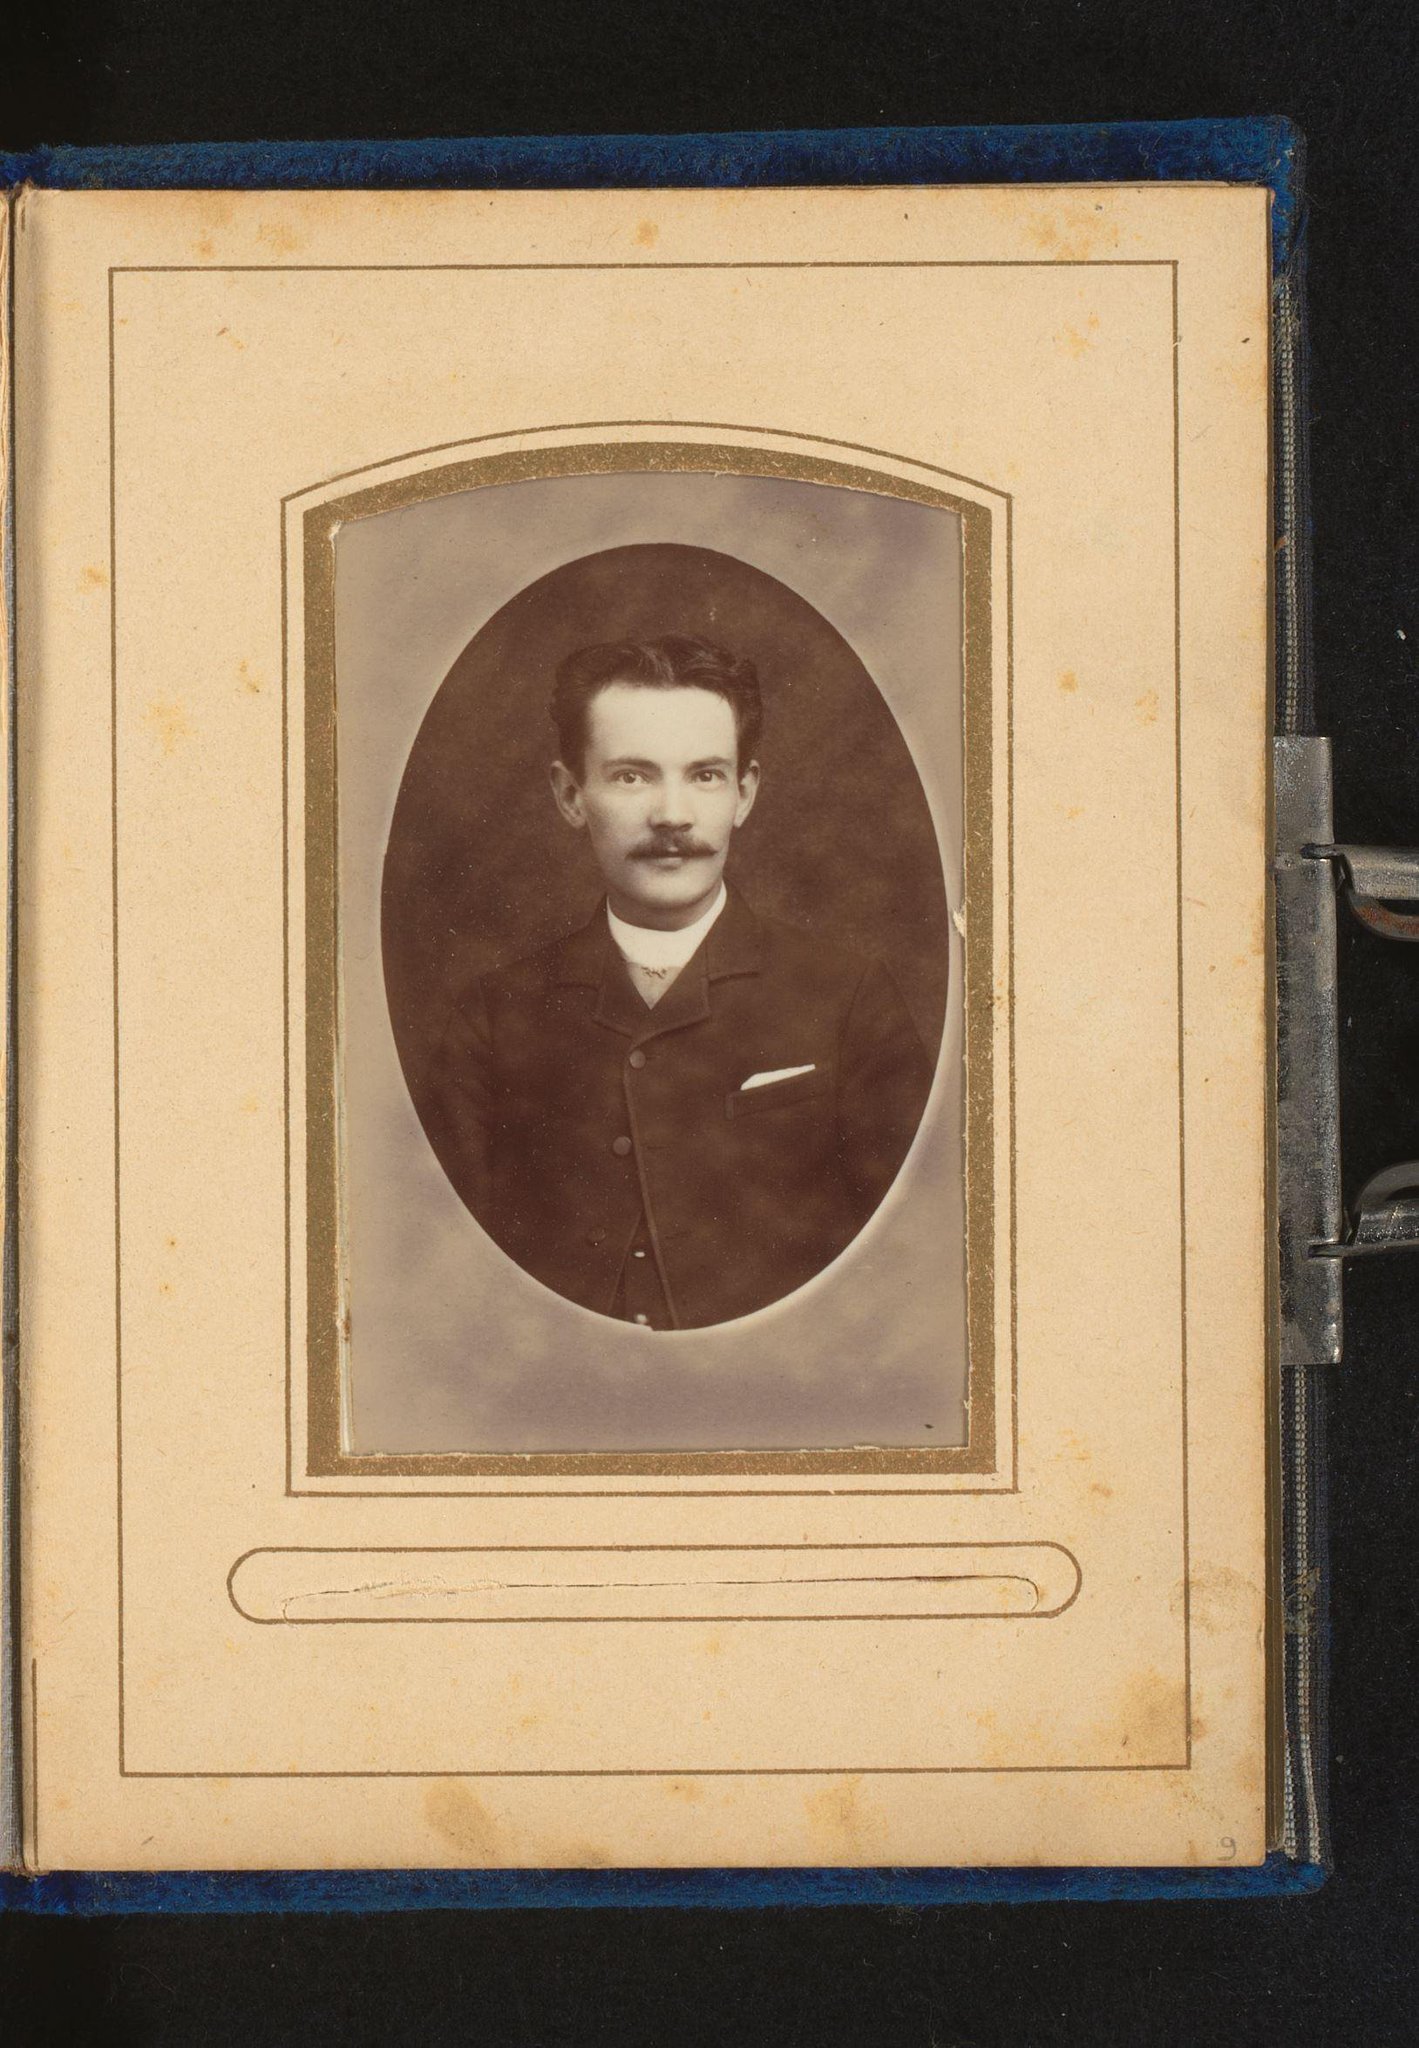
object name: semi enamel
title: Portret van een man met snor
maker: Anonymous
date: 1880-1900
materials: cardboard, celluloid, photographic support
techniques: albumen print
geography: france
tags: moustache, historical persons